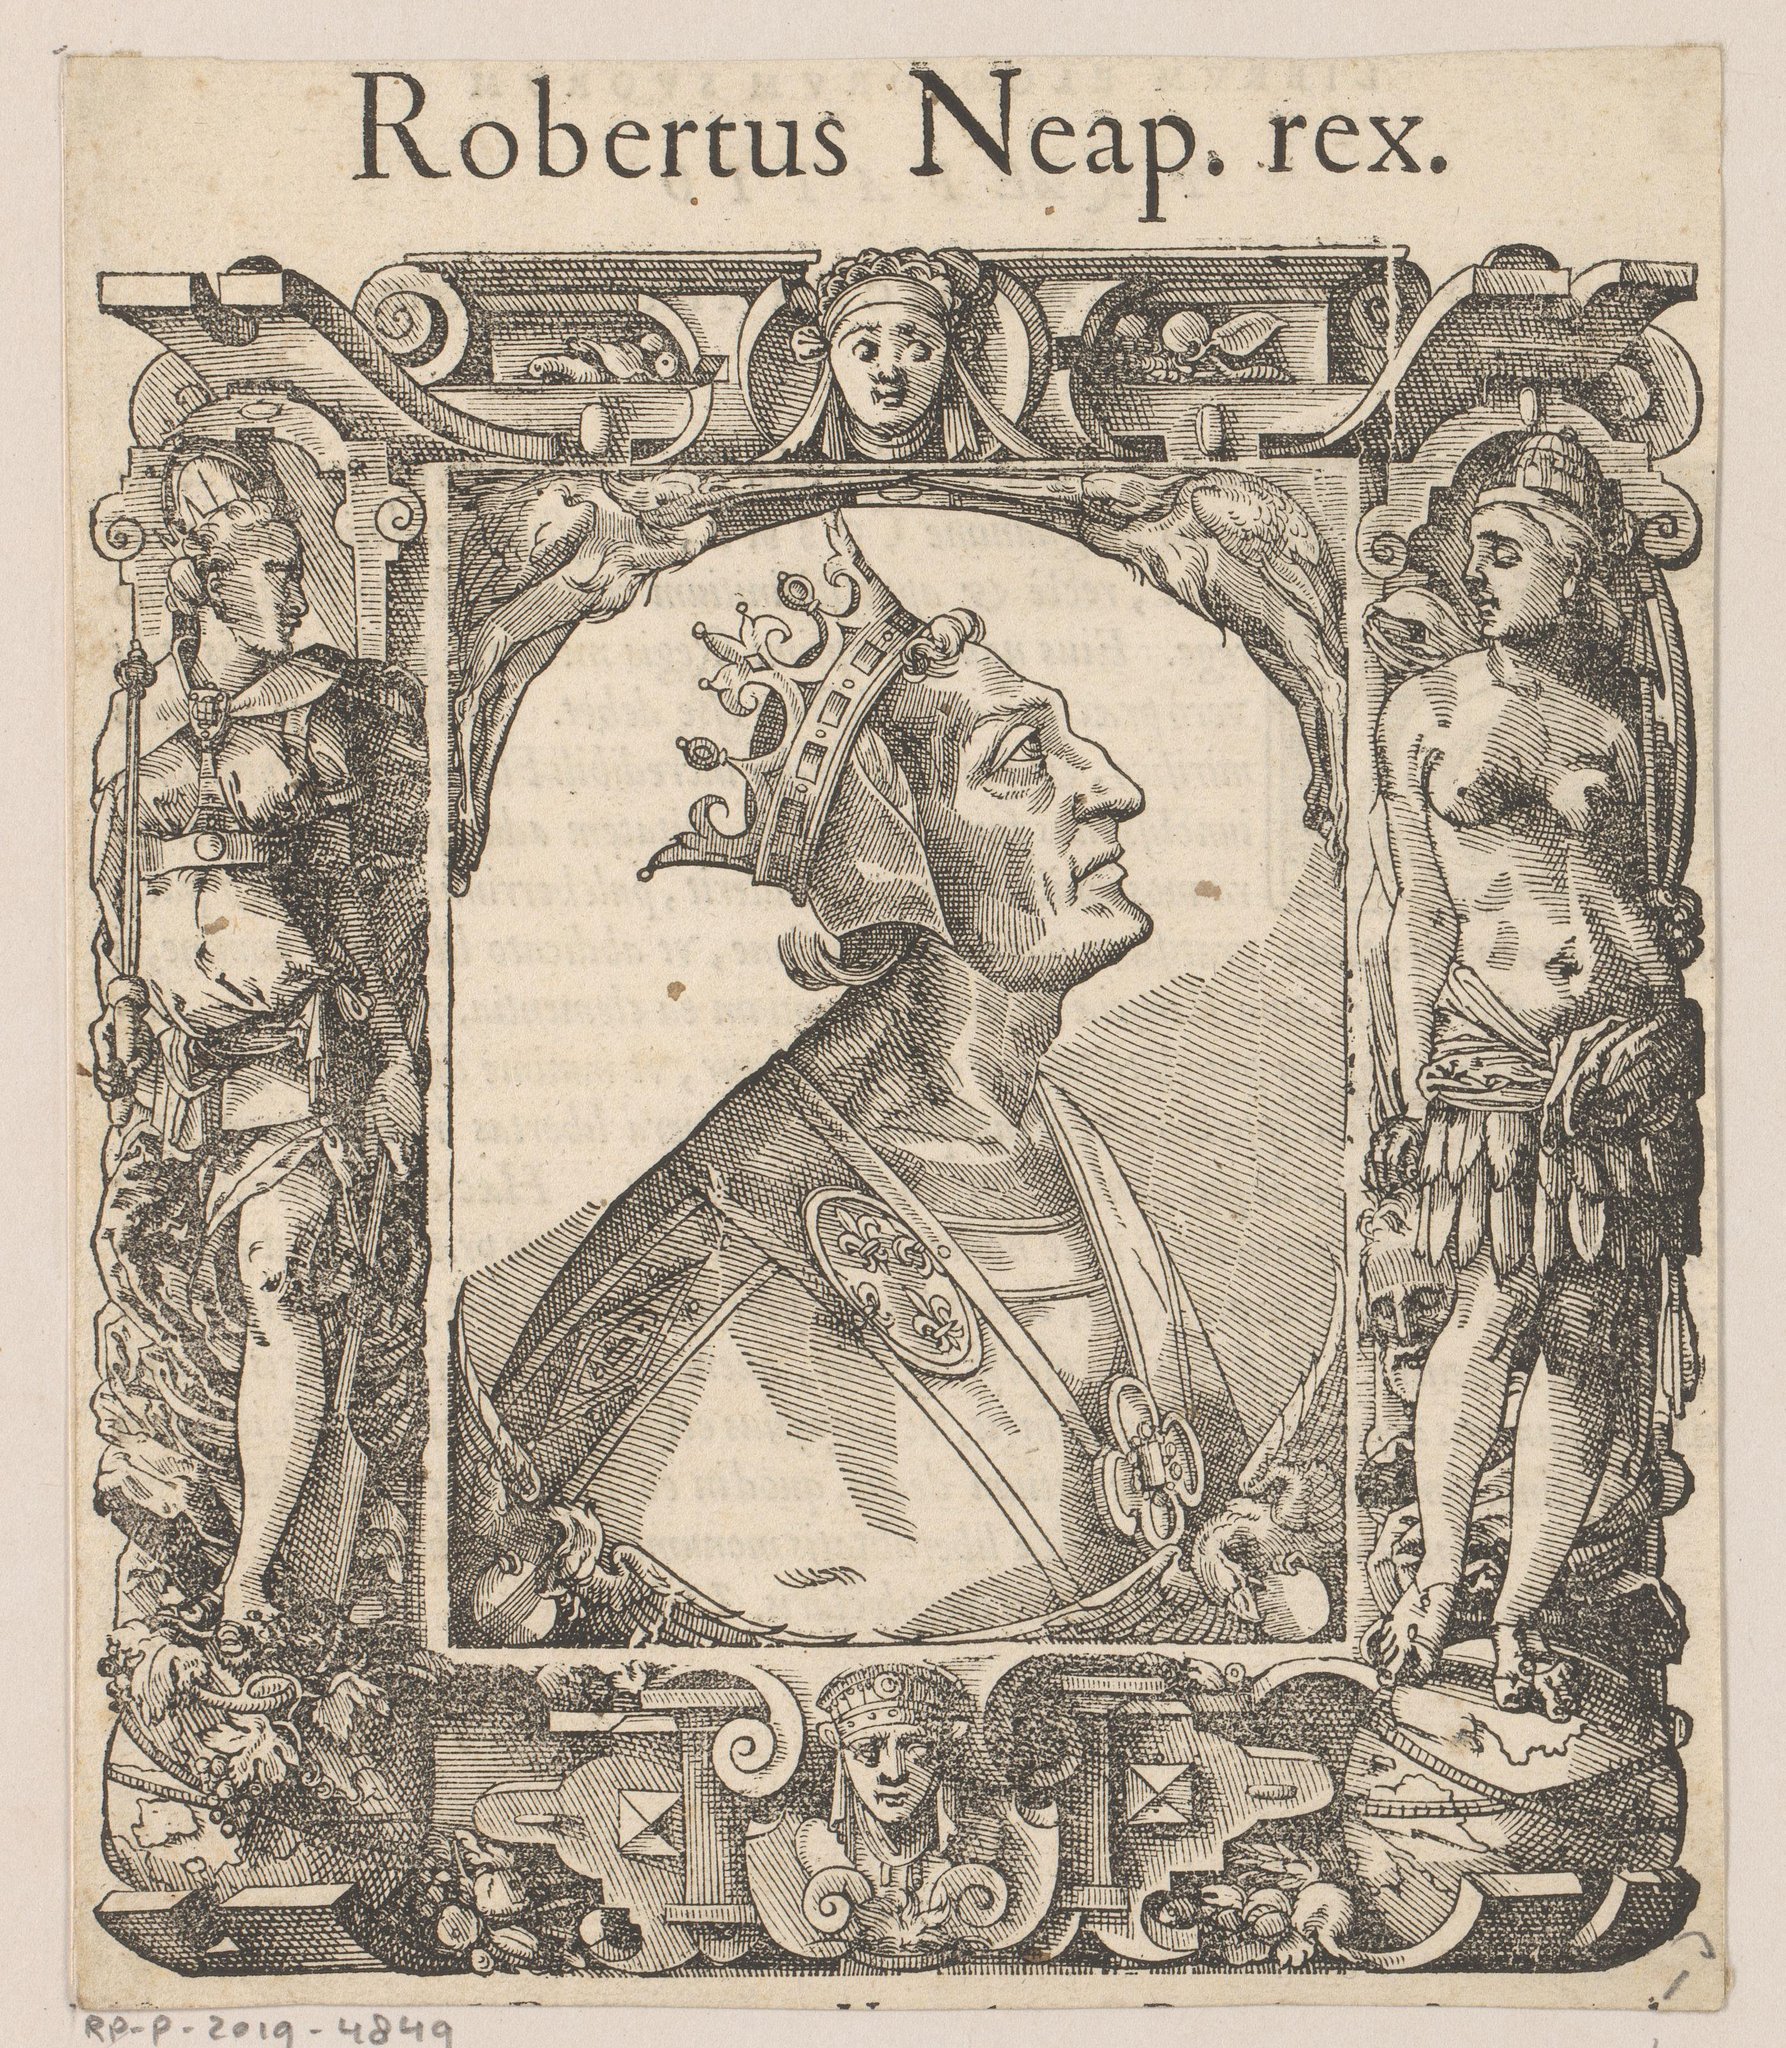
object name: print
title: Portret van Robert van Anjou, koning van Napels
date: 1575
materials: paper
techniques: letterpress printing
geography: basel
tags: earl, historical persons, king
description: Prent uit: Giovio, Paolo. Elogia virorum bellica virtute illustrium (...). Bazel: Peter Perna, 1575, p. 68. Prent mogelijk ook gebruikt in latere publicaties.